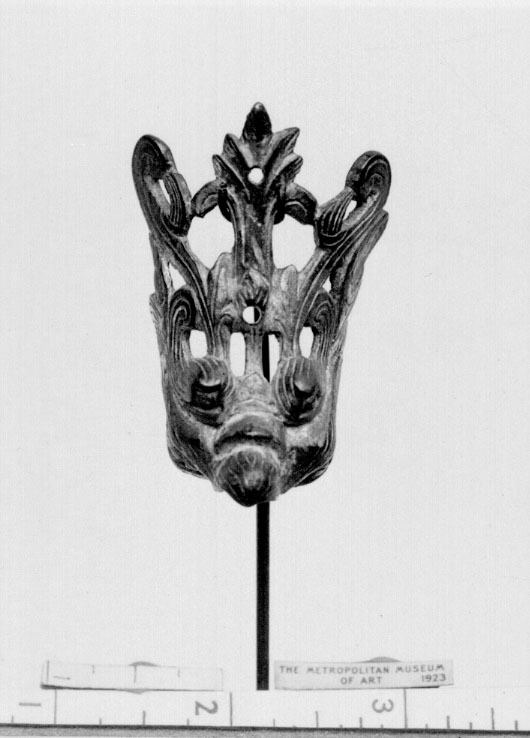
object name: fragment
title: Fragment of a Buddhist crown?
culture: chinese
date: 201-600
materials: gilt bronze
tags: masks